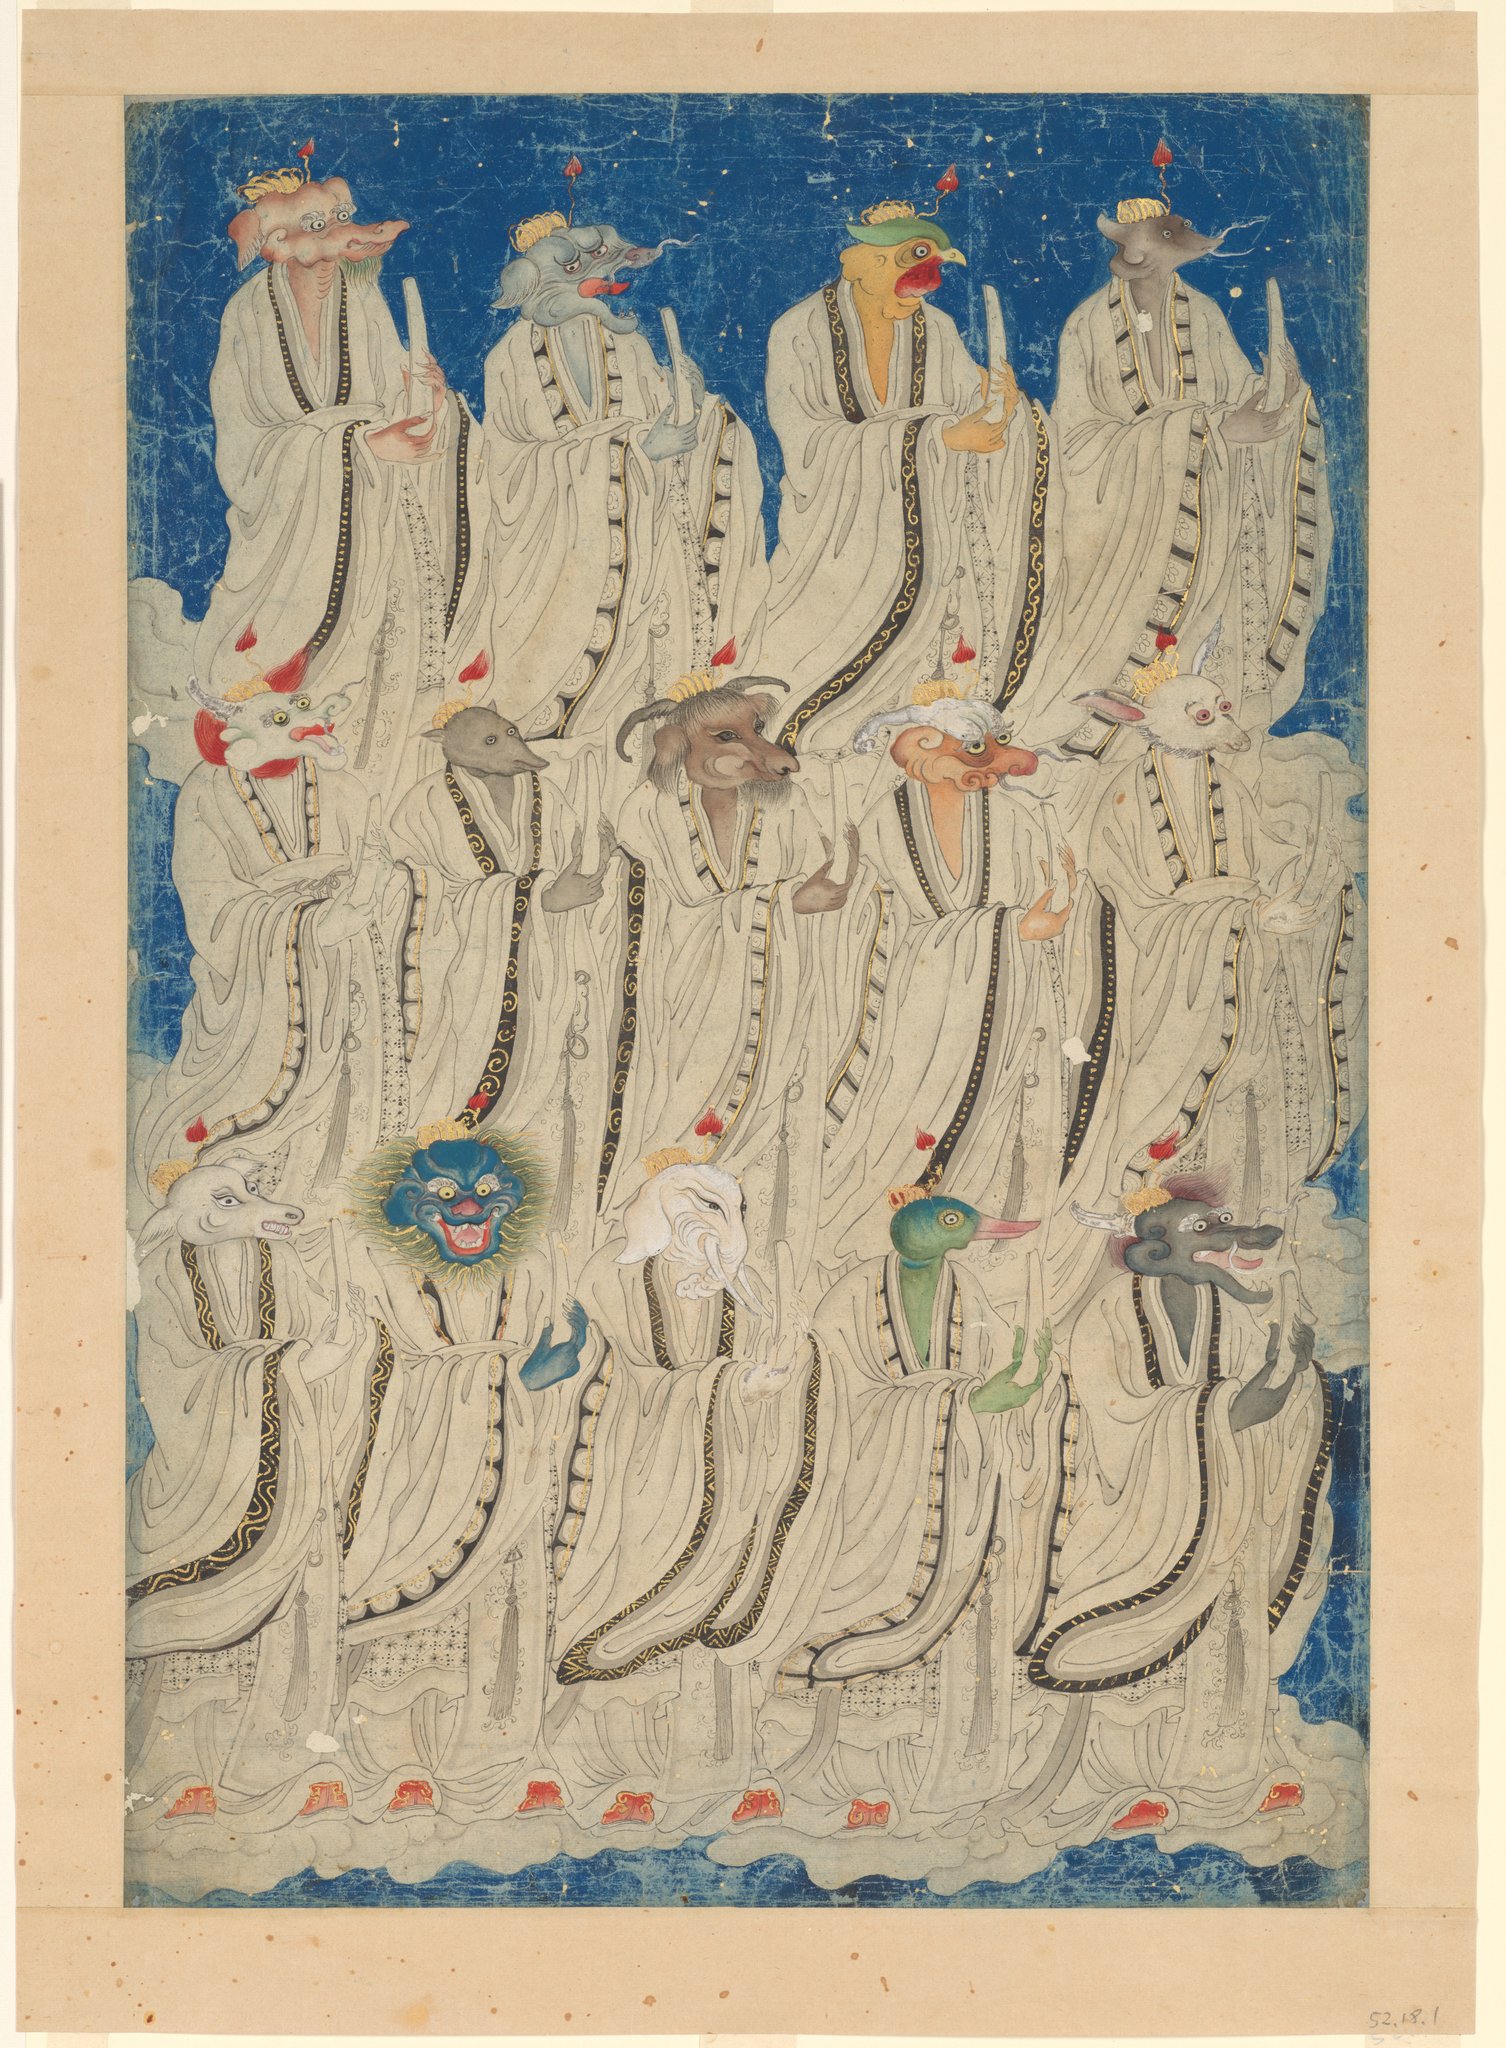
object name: hanging scroll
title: Fourteen Constellations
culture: chinese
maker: unidentified artist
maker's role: artist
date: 1667-1700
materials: ink, paper